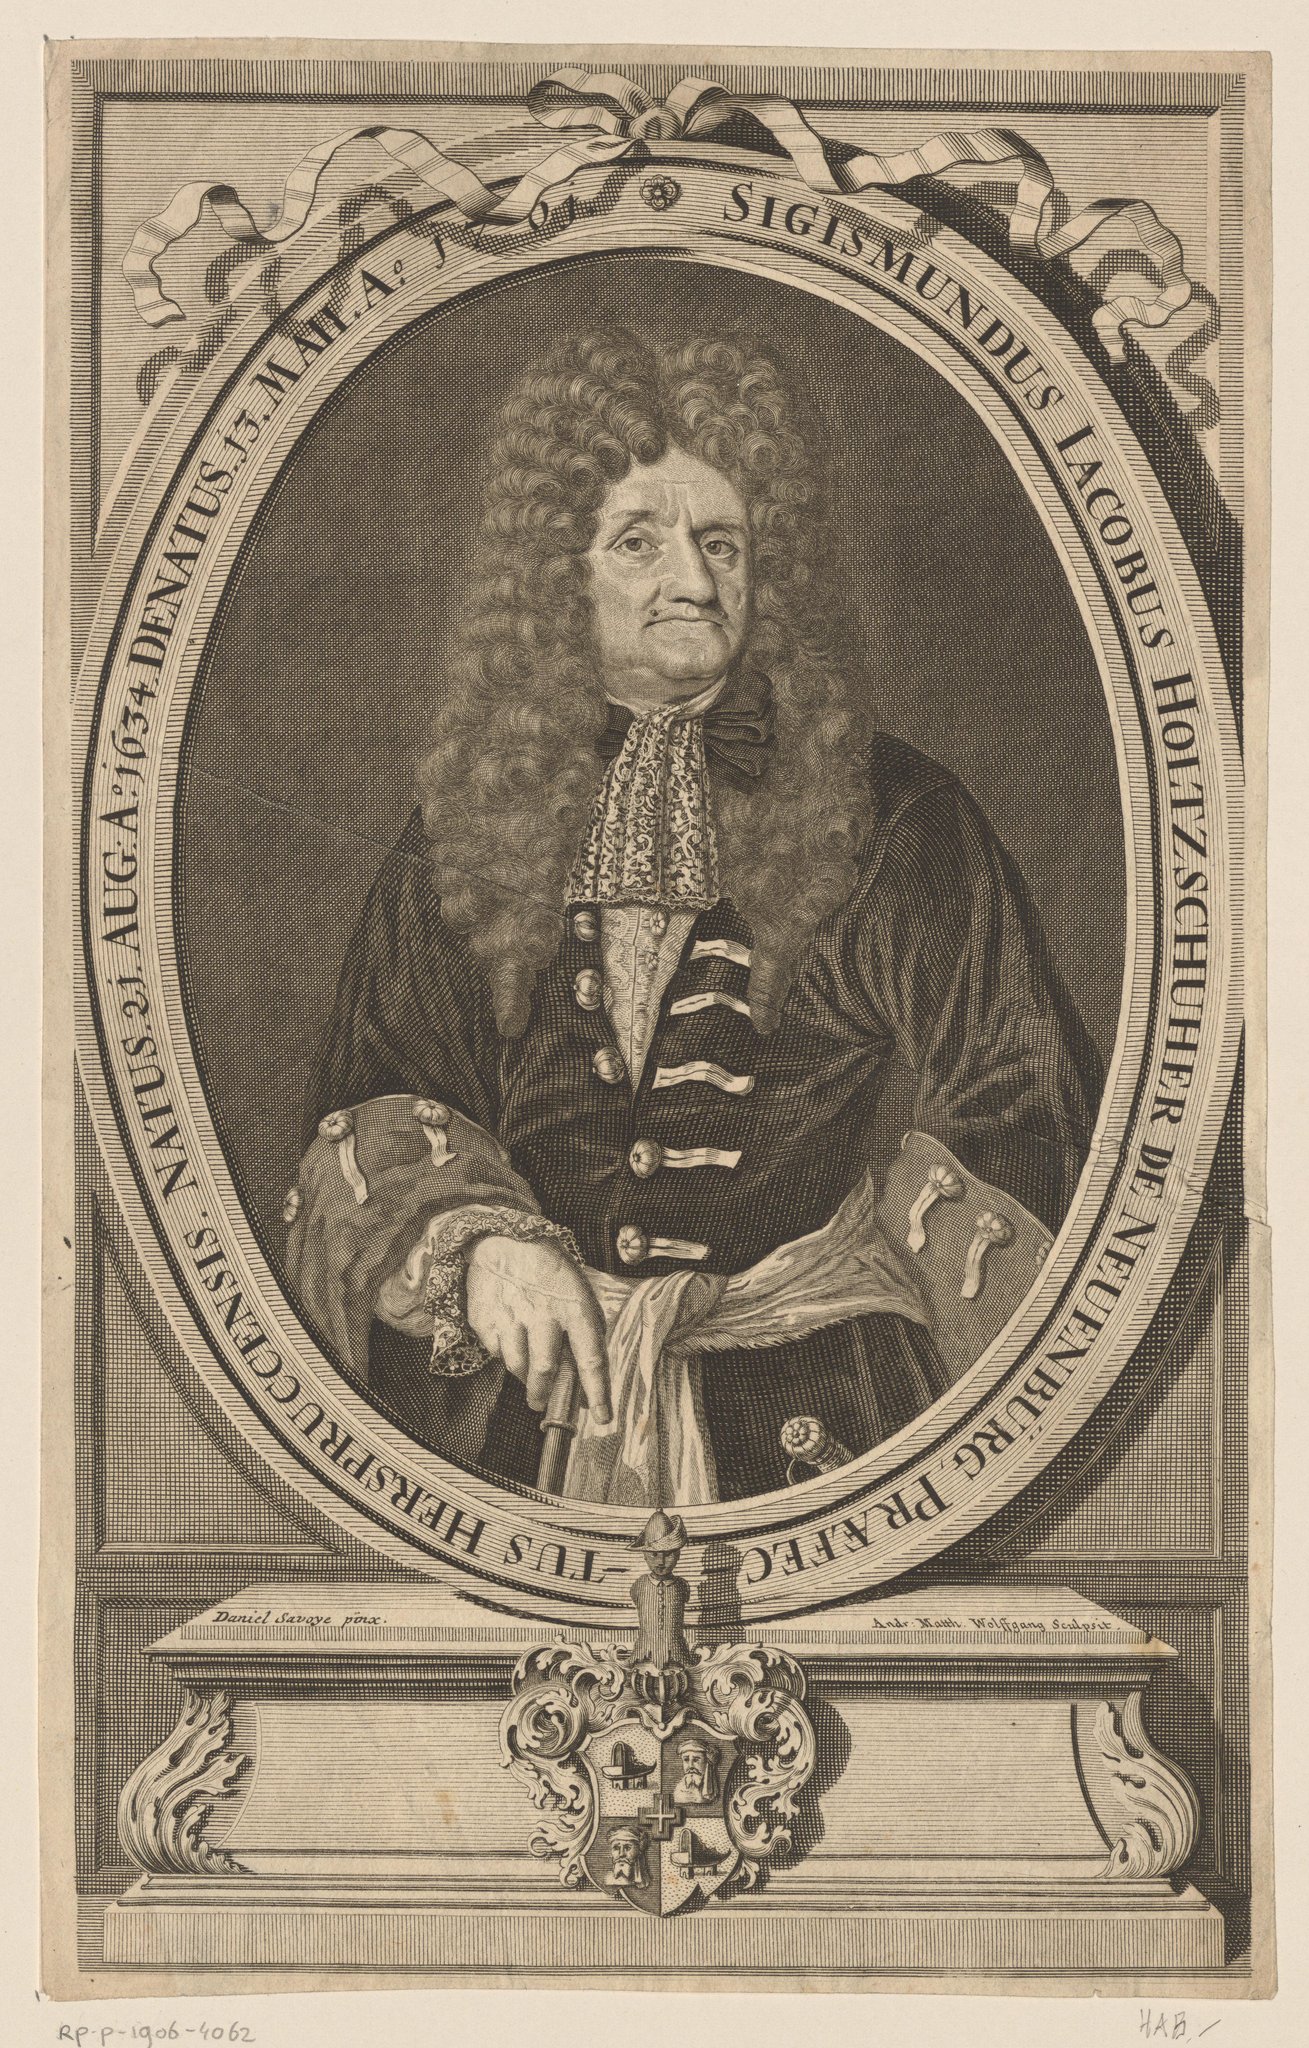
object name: print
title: Portret van Sigismund Jacob Holtzschuher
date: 1670-1737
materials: paper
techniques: engraving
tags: adult man, historical persons, armorial bearing, heraldry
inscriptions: collector's mark: Lugt 2228